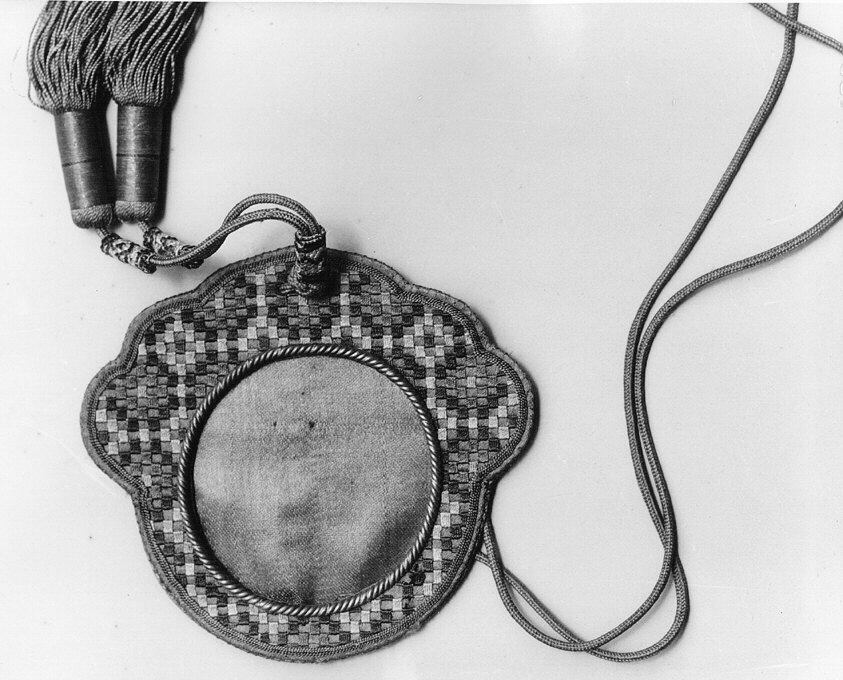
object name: mirror case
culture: chinese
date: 1701-1900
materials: metal thread, silk